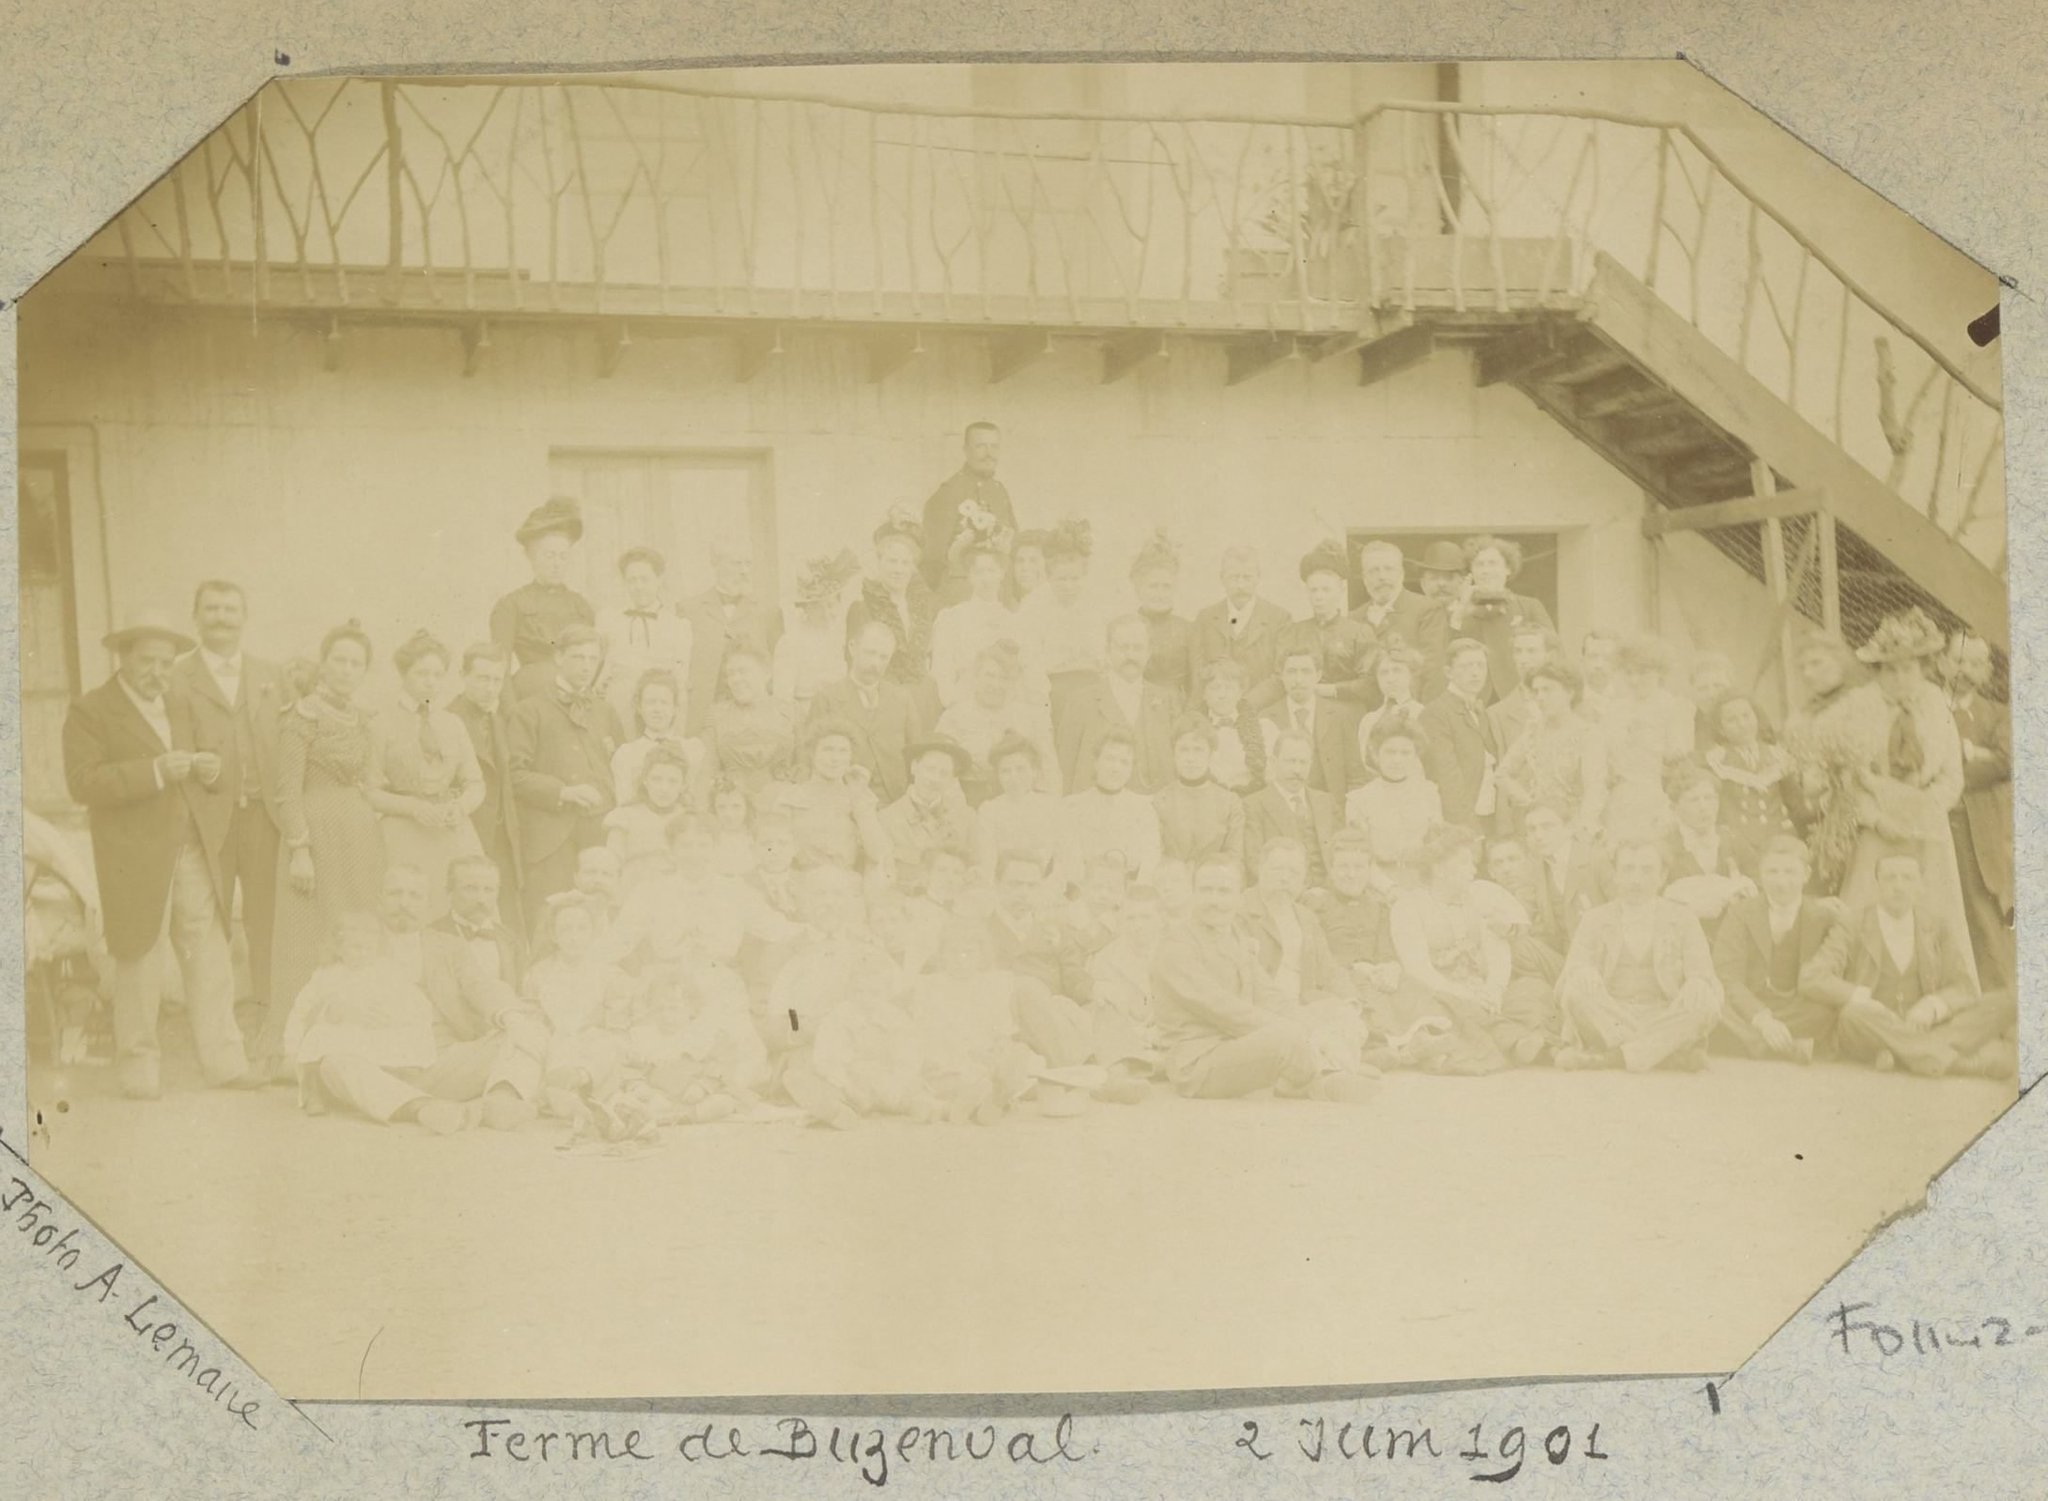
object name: album leaf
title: Groepsportret van een gezelschap op de Ferme de Buzenval in Frankrijk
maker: Anonymous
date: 1901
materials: paper, photographic support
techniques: daylight paper print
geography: france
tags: adult woman, adult man, farm (building), france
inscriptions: name: ‘Photo A. Lema[...]e’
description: Onderdeel van Album van een Franse amateur met foto's van Frankrijk, Algerije, Palmyra, de Wereldtentoonstelling van 1900 en van bekende Fransen.